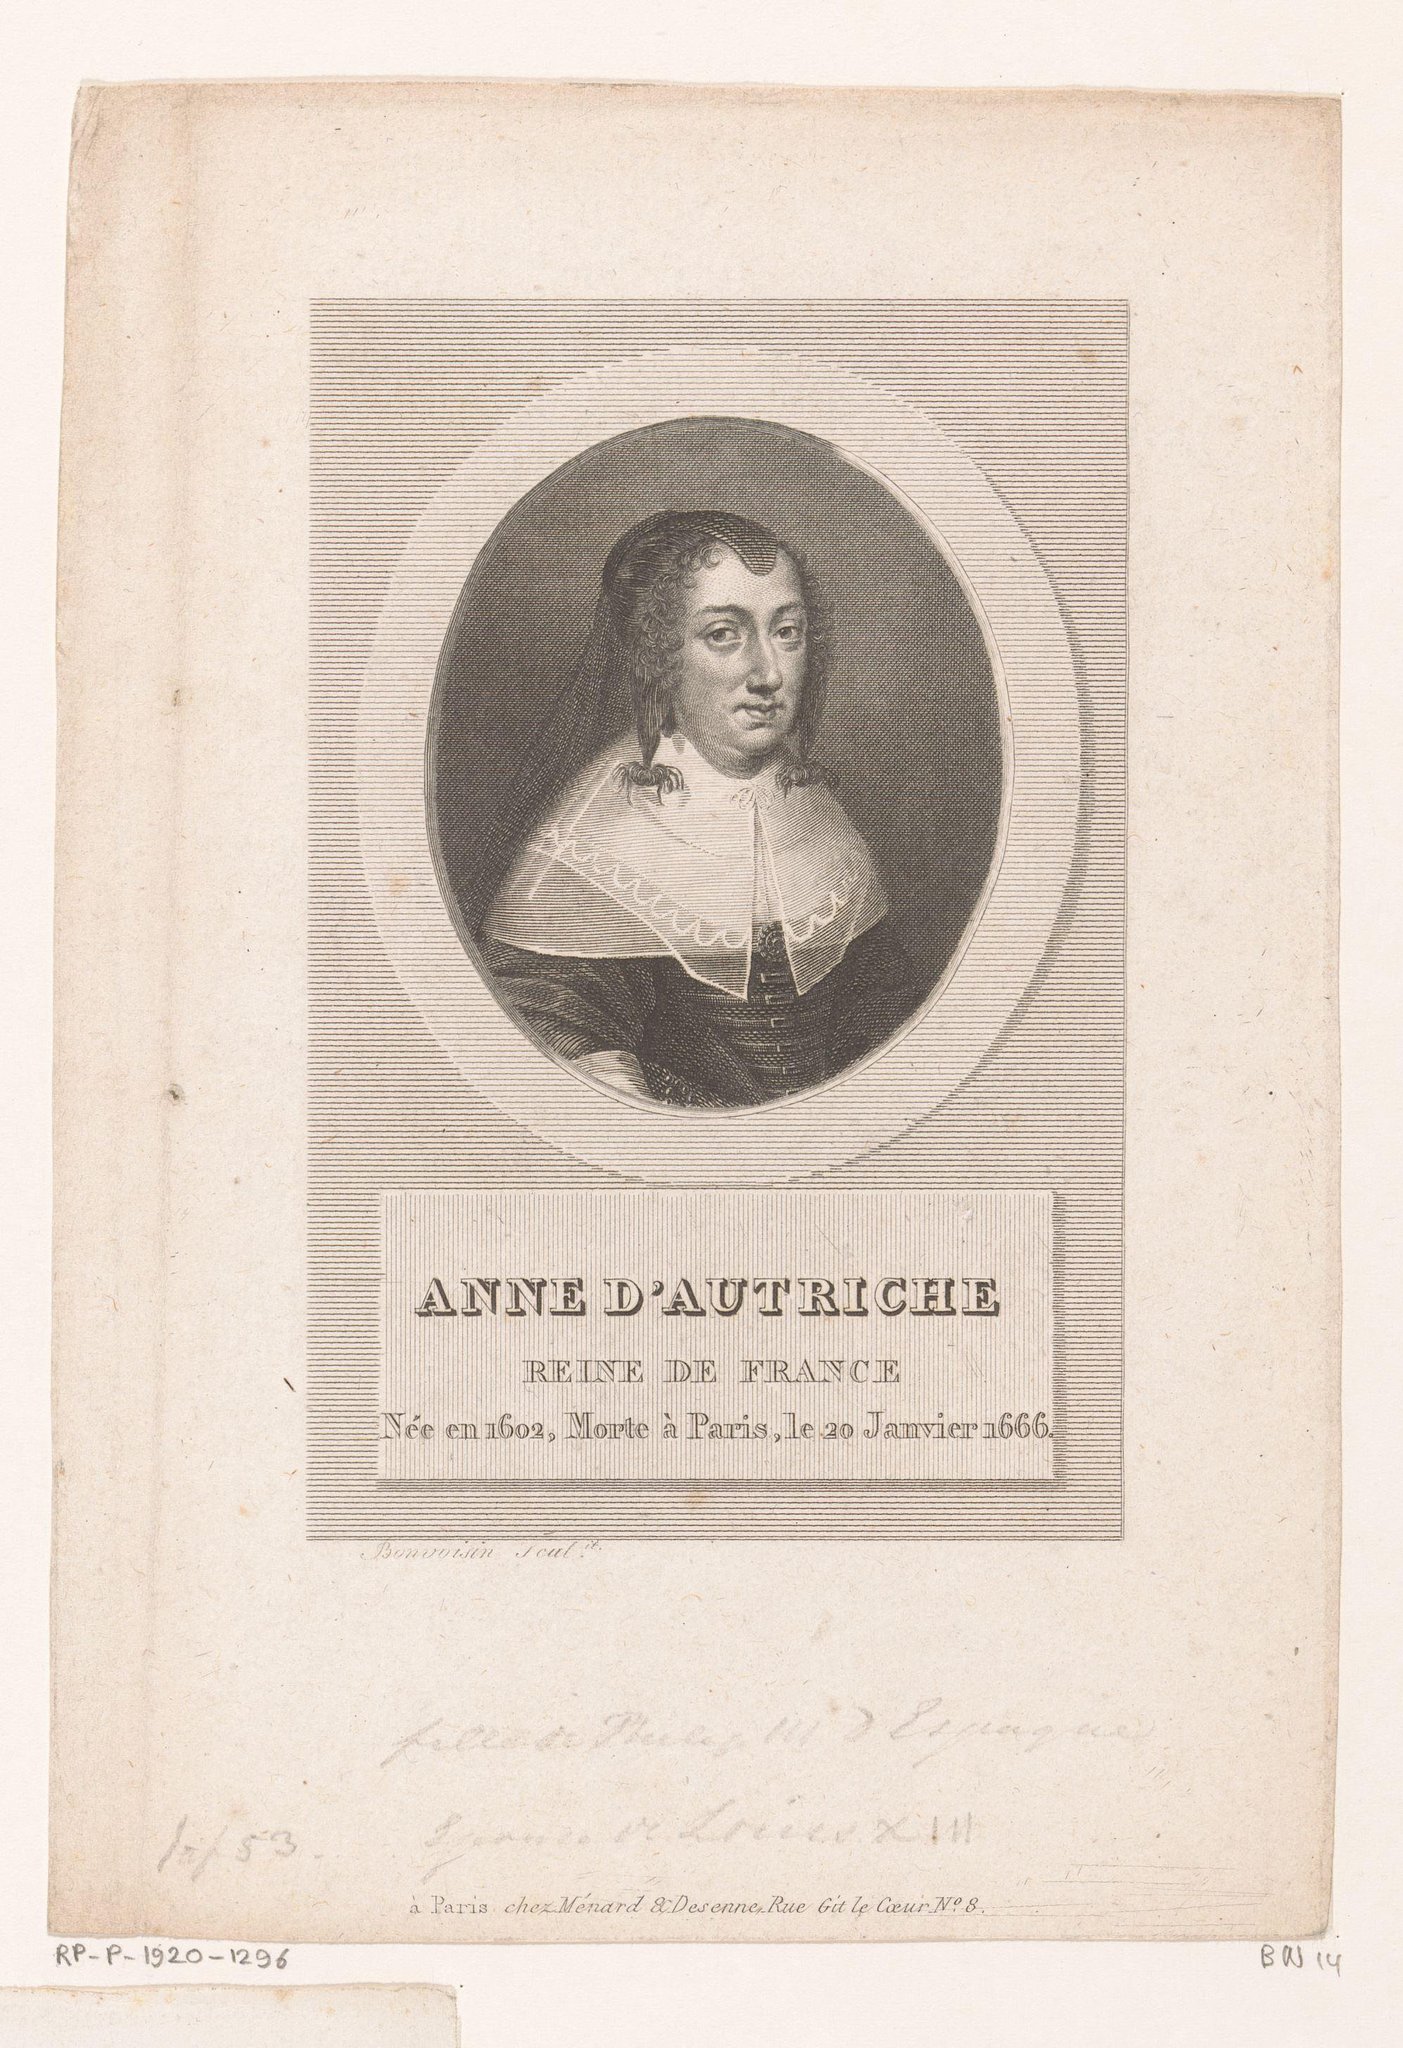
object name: print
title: Portret van Anna van Oostenrijk (koningin van Frankrijk)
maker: jean bonvoisin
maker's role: print maker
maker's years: 1752-1837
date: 1816-1831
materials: paper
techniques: engraving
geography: paris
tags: anna van oostenrijk (koningin van frankrijk), historical persons, queen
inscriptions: collector's mark: Lugt 2228